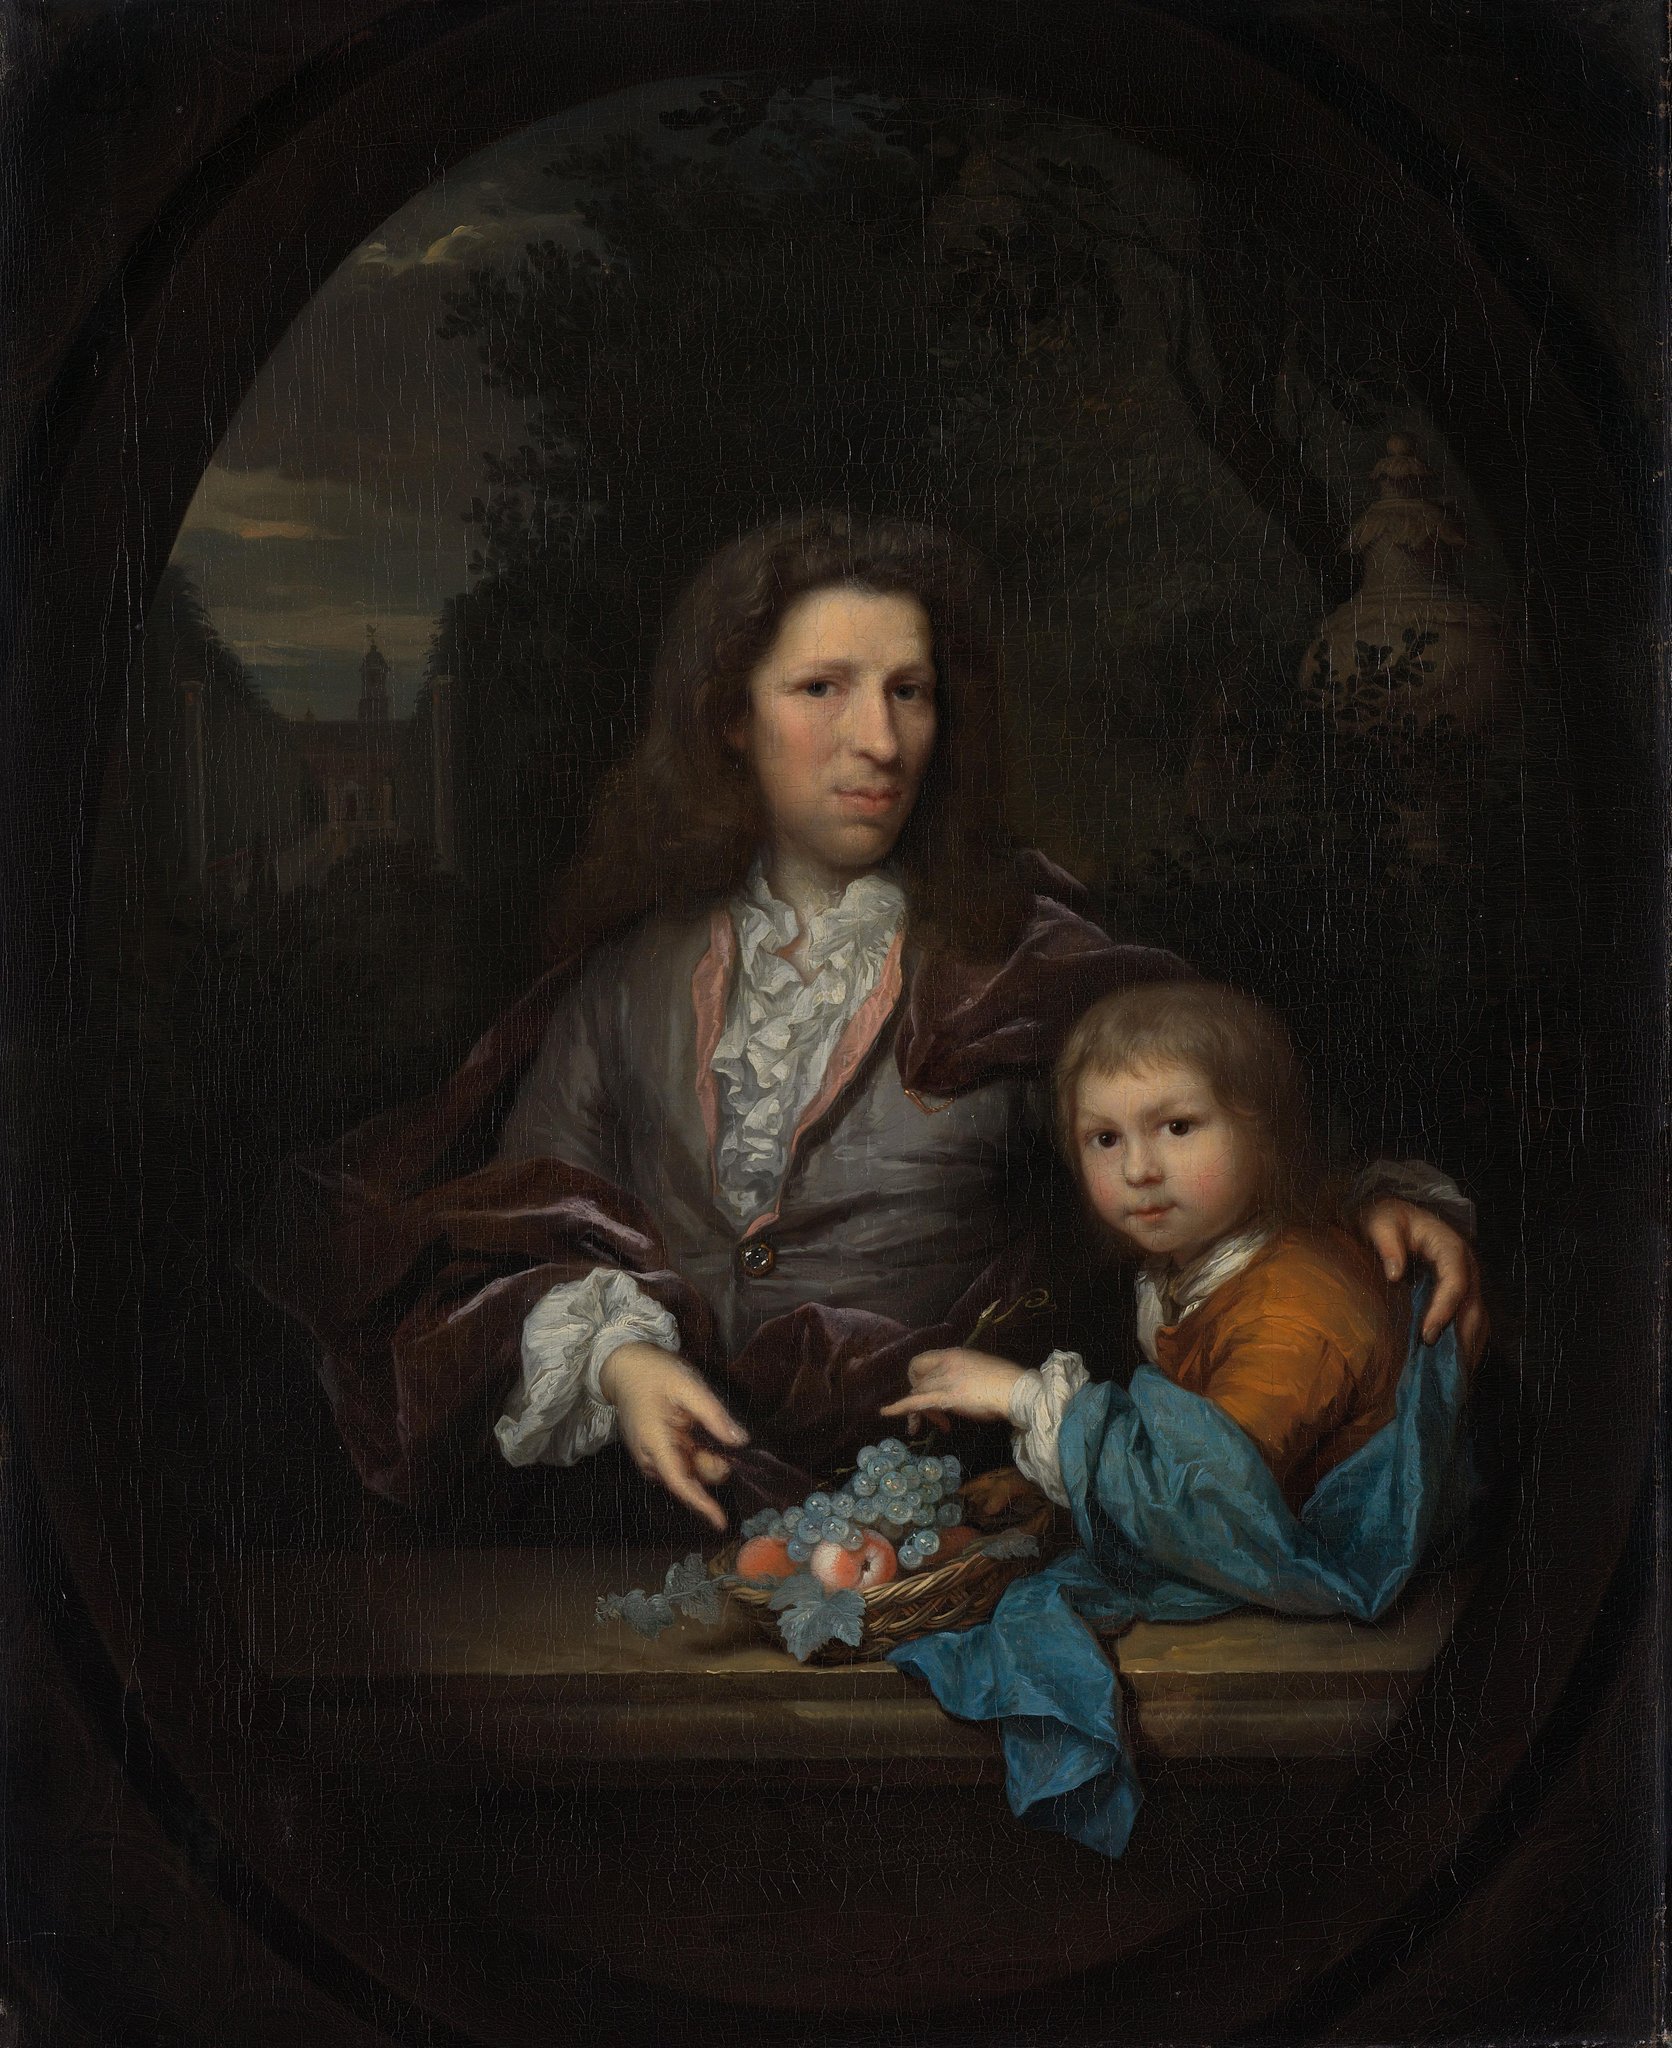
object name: painting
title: Jan van de Poll (1668-1745) and his Son Harmen Hendrick (1697-1772).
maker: arnold boonen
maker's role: draughtsman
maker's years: 1669-1729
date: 1700-1729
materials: canvas, oil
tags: mayor, burgomaster, historical persons, father and son(s) (family group), amsterdam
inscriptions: signature: ‘A. Boonen’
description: Portret van Jan van de Poll en zijn zoon Harmen Hendrick. Borstbeelden achter een stenen plint met een mand met druiven en andere vruchten. Pendant van SK-A-1267.